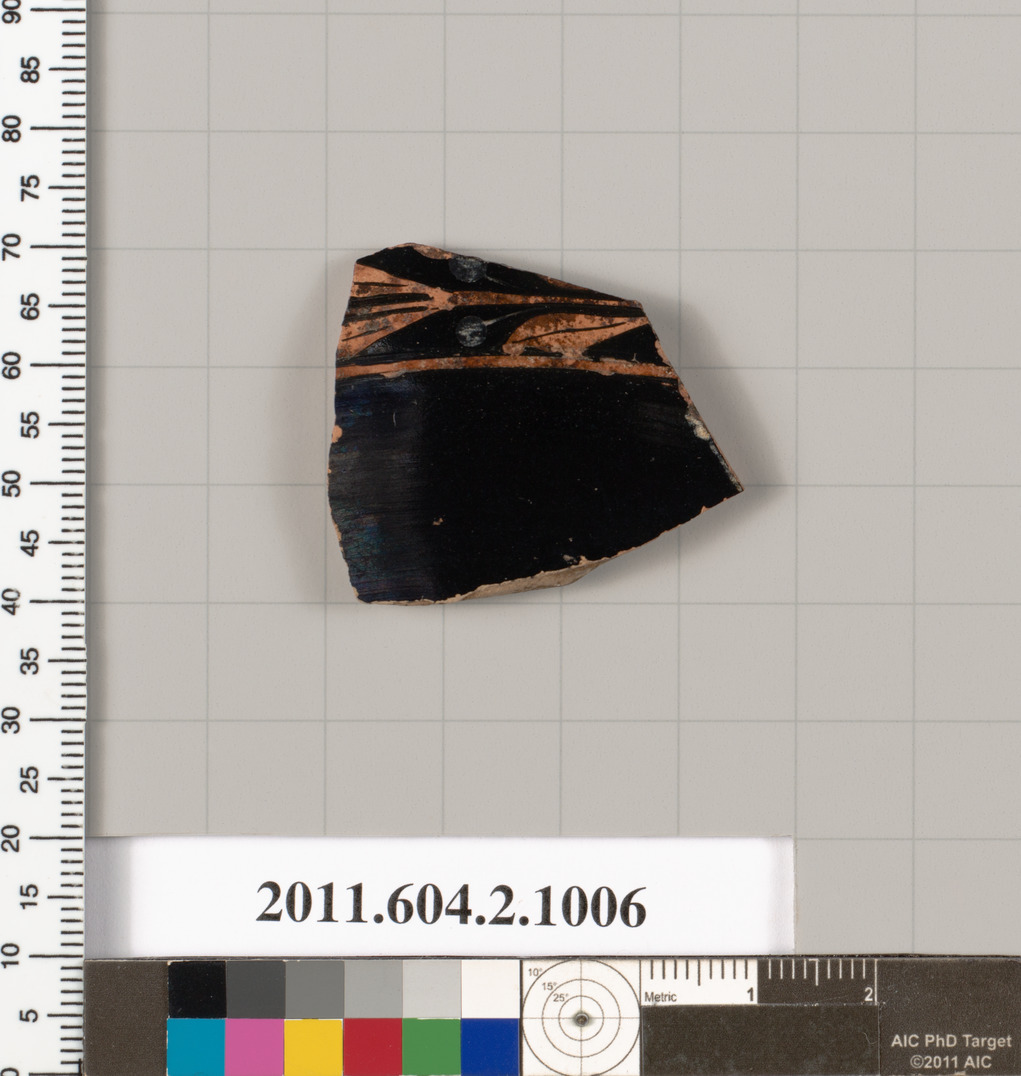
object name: oinochoe fragment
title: Terracotta fragment of an oinochoe (jug)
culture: greek, attic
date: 460-440 BCE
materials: terracotta